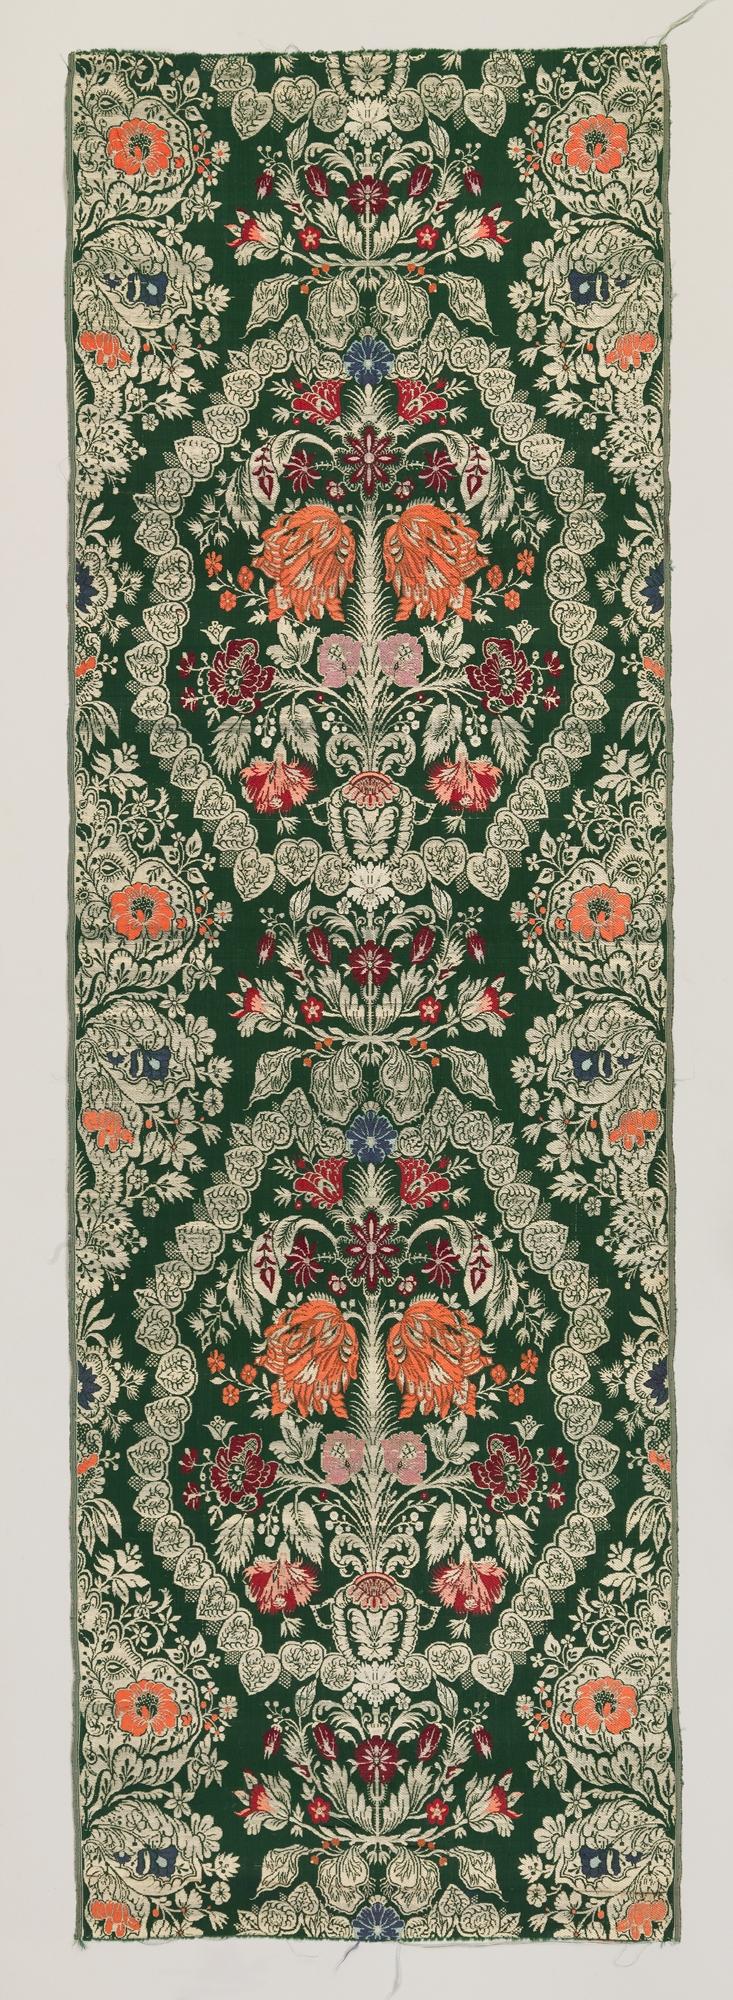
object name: length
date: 1701-1800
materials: silk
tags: flowers